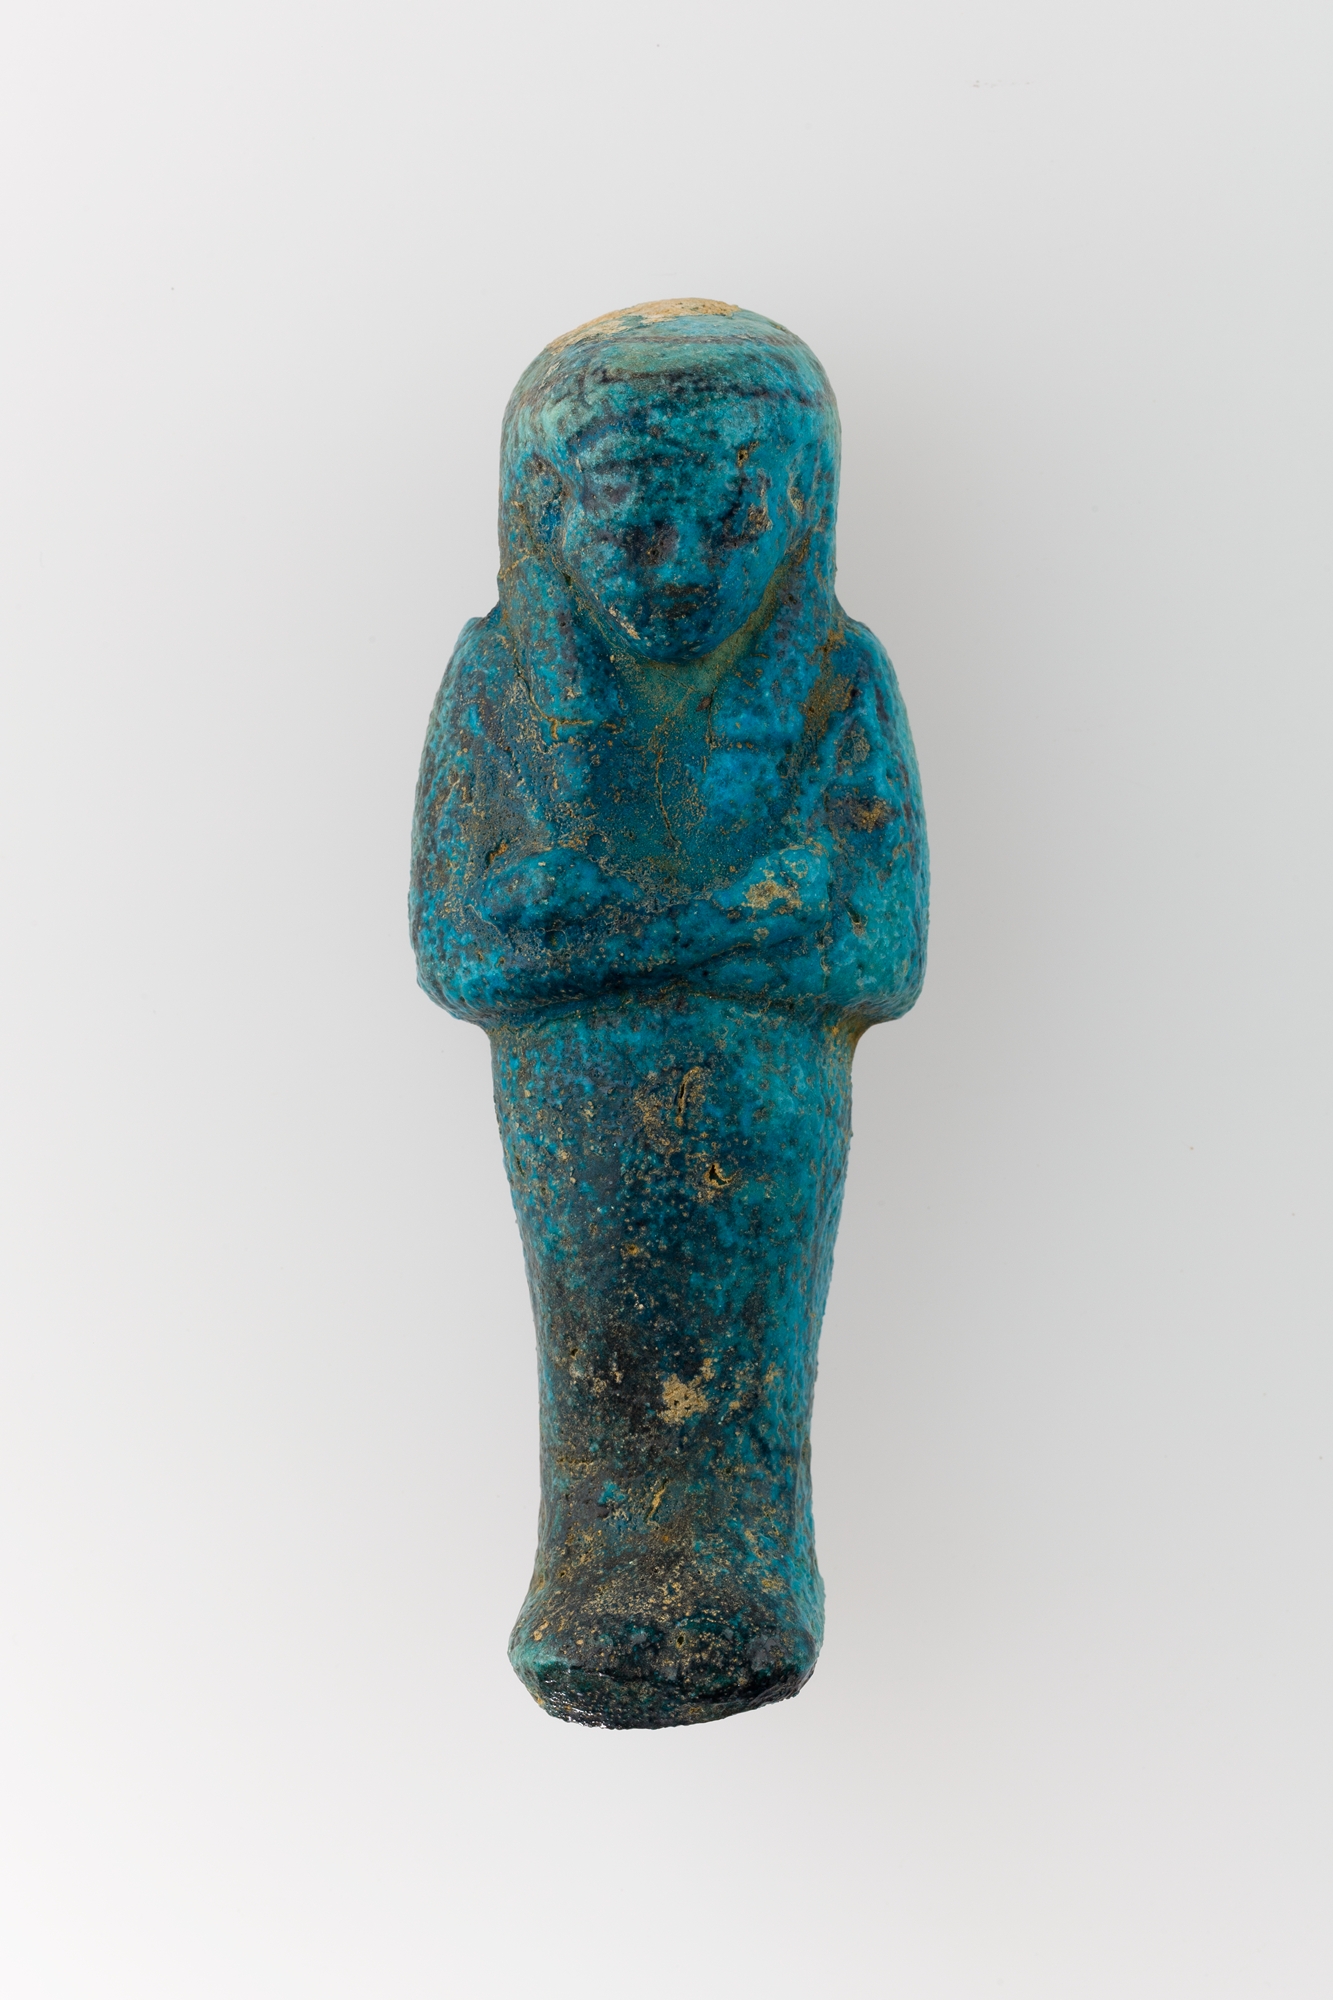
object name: shabti, henettawy c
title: Worker Shabti of Henettawy (C), Daughter of Isetemkheb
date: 990-970 BCE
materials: faience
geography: egypt